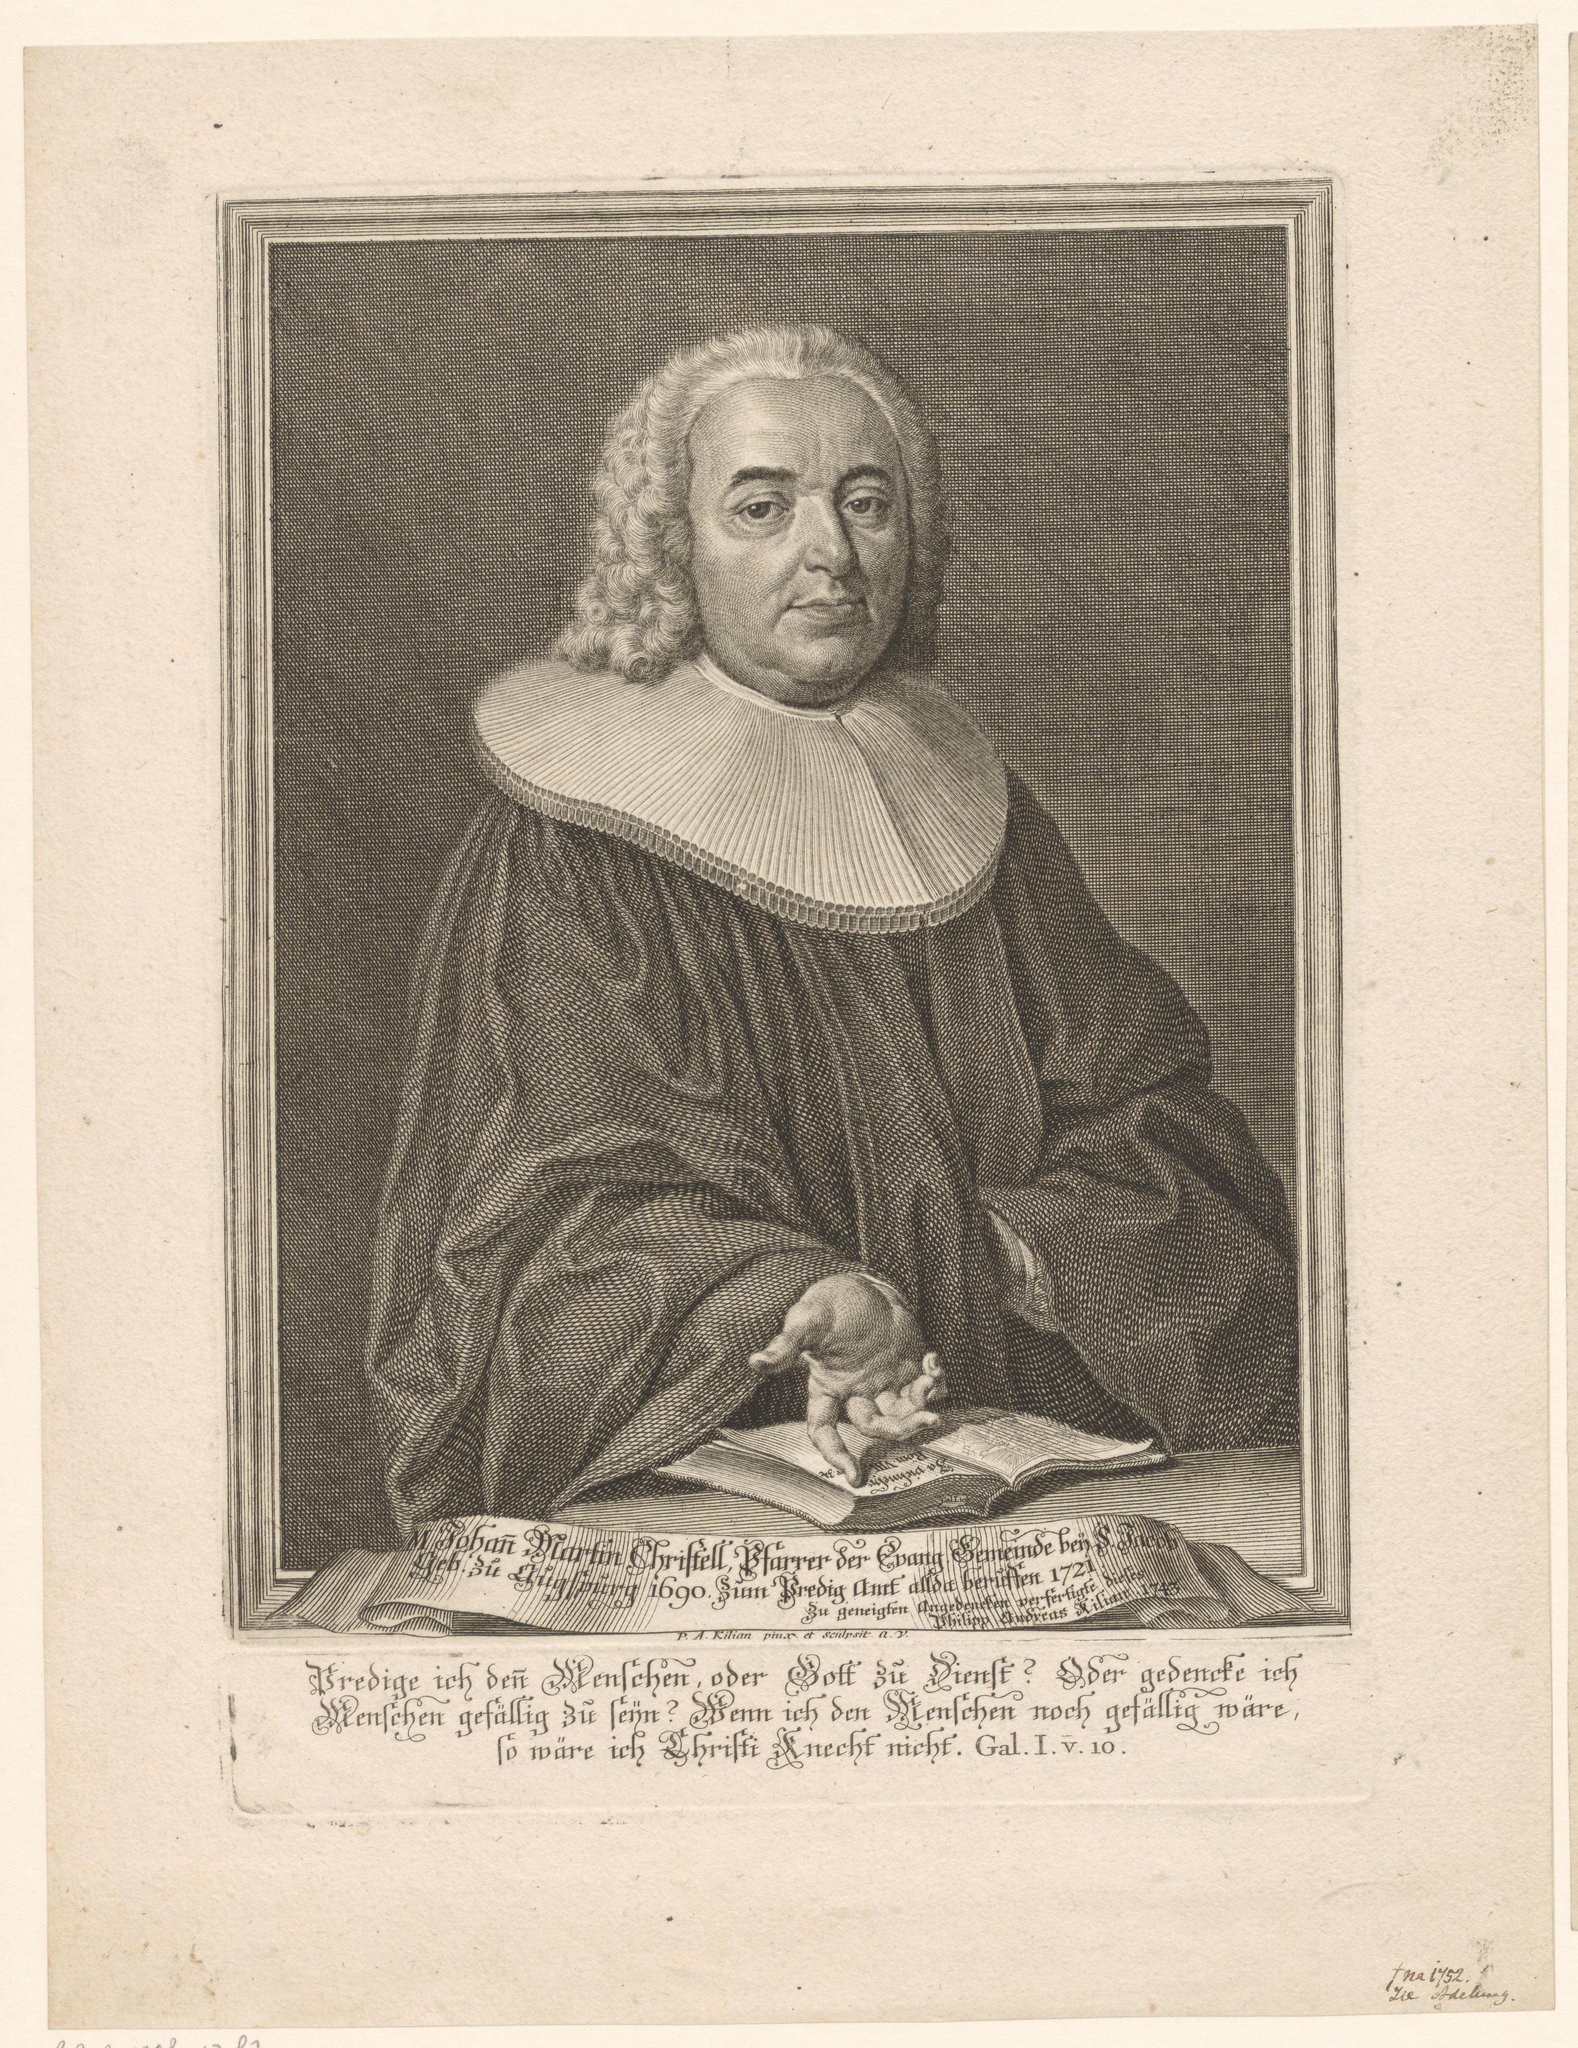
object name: print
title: Portret van Johann Martin Christell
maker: philipp andreas kilian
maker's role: artist, painter, print maker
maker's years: 1714-1759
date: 1743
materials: paper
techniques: engraving, etching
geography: augsburg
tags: johann martin christell, theologian, historical persons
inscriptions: collector's mark: Lugt 2228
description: Tekst in het Latijn op de banderol en in de ondermarge.